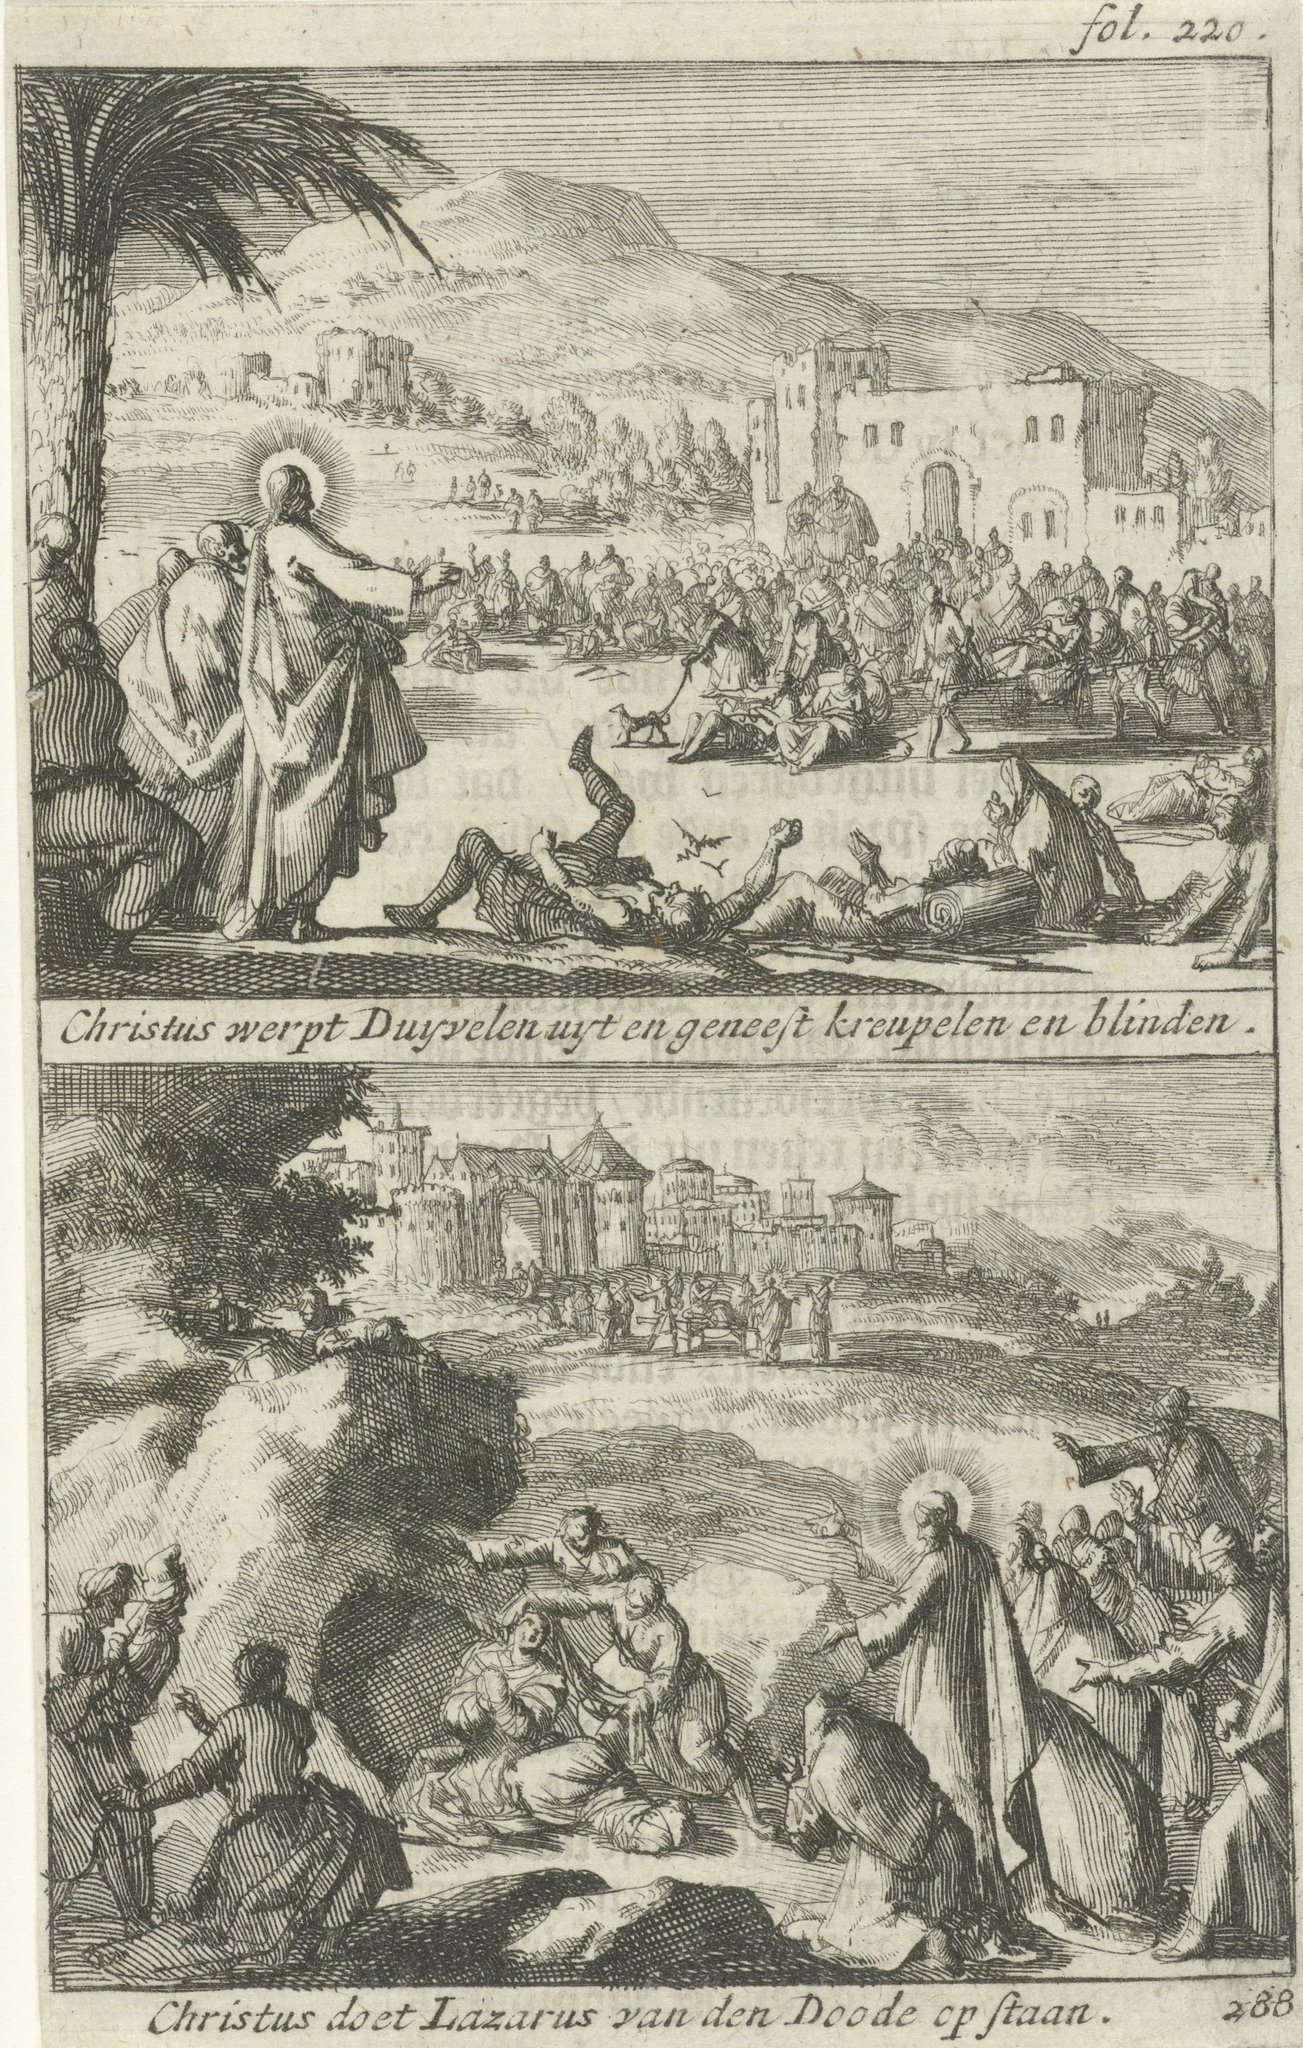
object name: book illustration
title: Christus werpt Duyvelen uyt en geneest kreupelen en blinden / Christus doet Lazarus van den Doode opstaan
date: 1690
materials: paper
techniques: etching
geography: amsterdam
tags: the raising of lazarus ('lazarus, come out'), disabilities, deformations, miracles of christ ~ healing the sick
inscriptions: collector's mark: Lugt 2228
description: Illustratie uit: Garthwait, Henry. Historie des levens en stervens onses Heeren en saligmakers Jesu Christi. Amsterdam: Jan Claesz ten Hoorn, 1690.